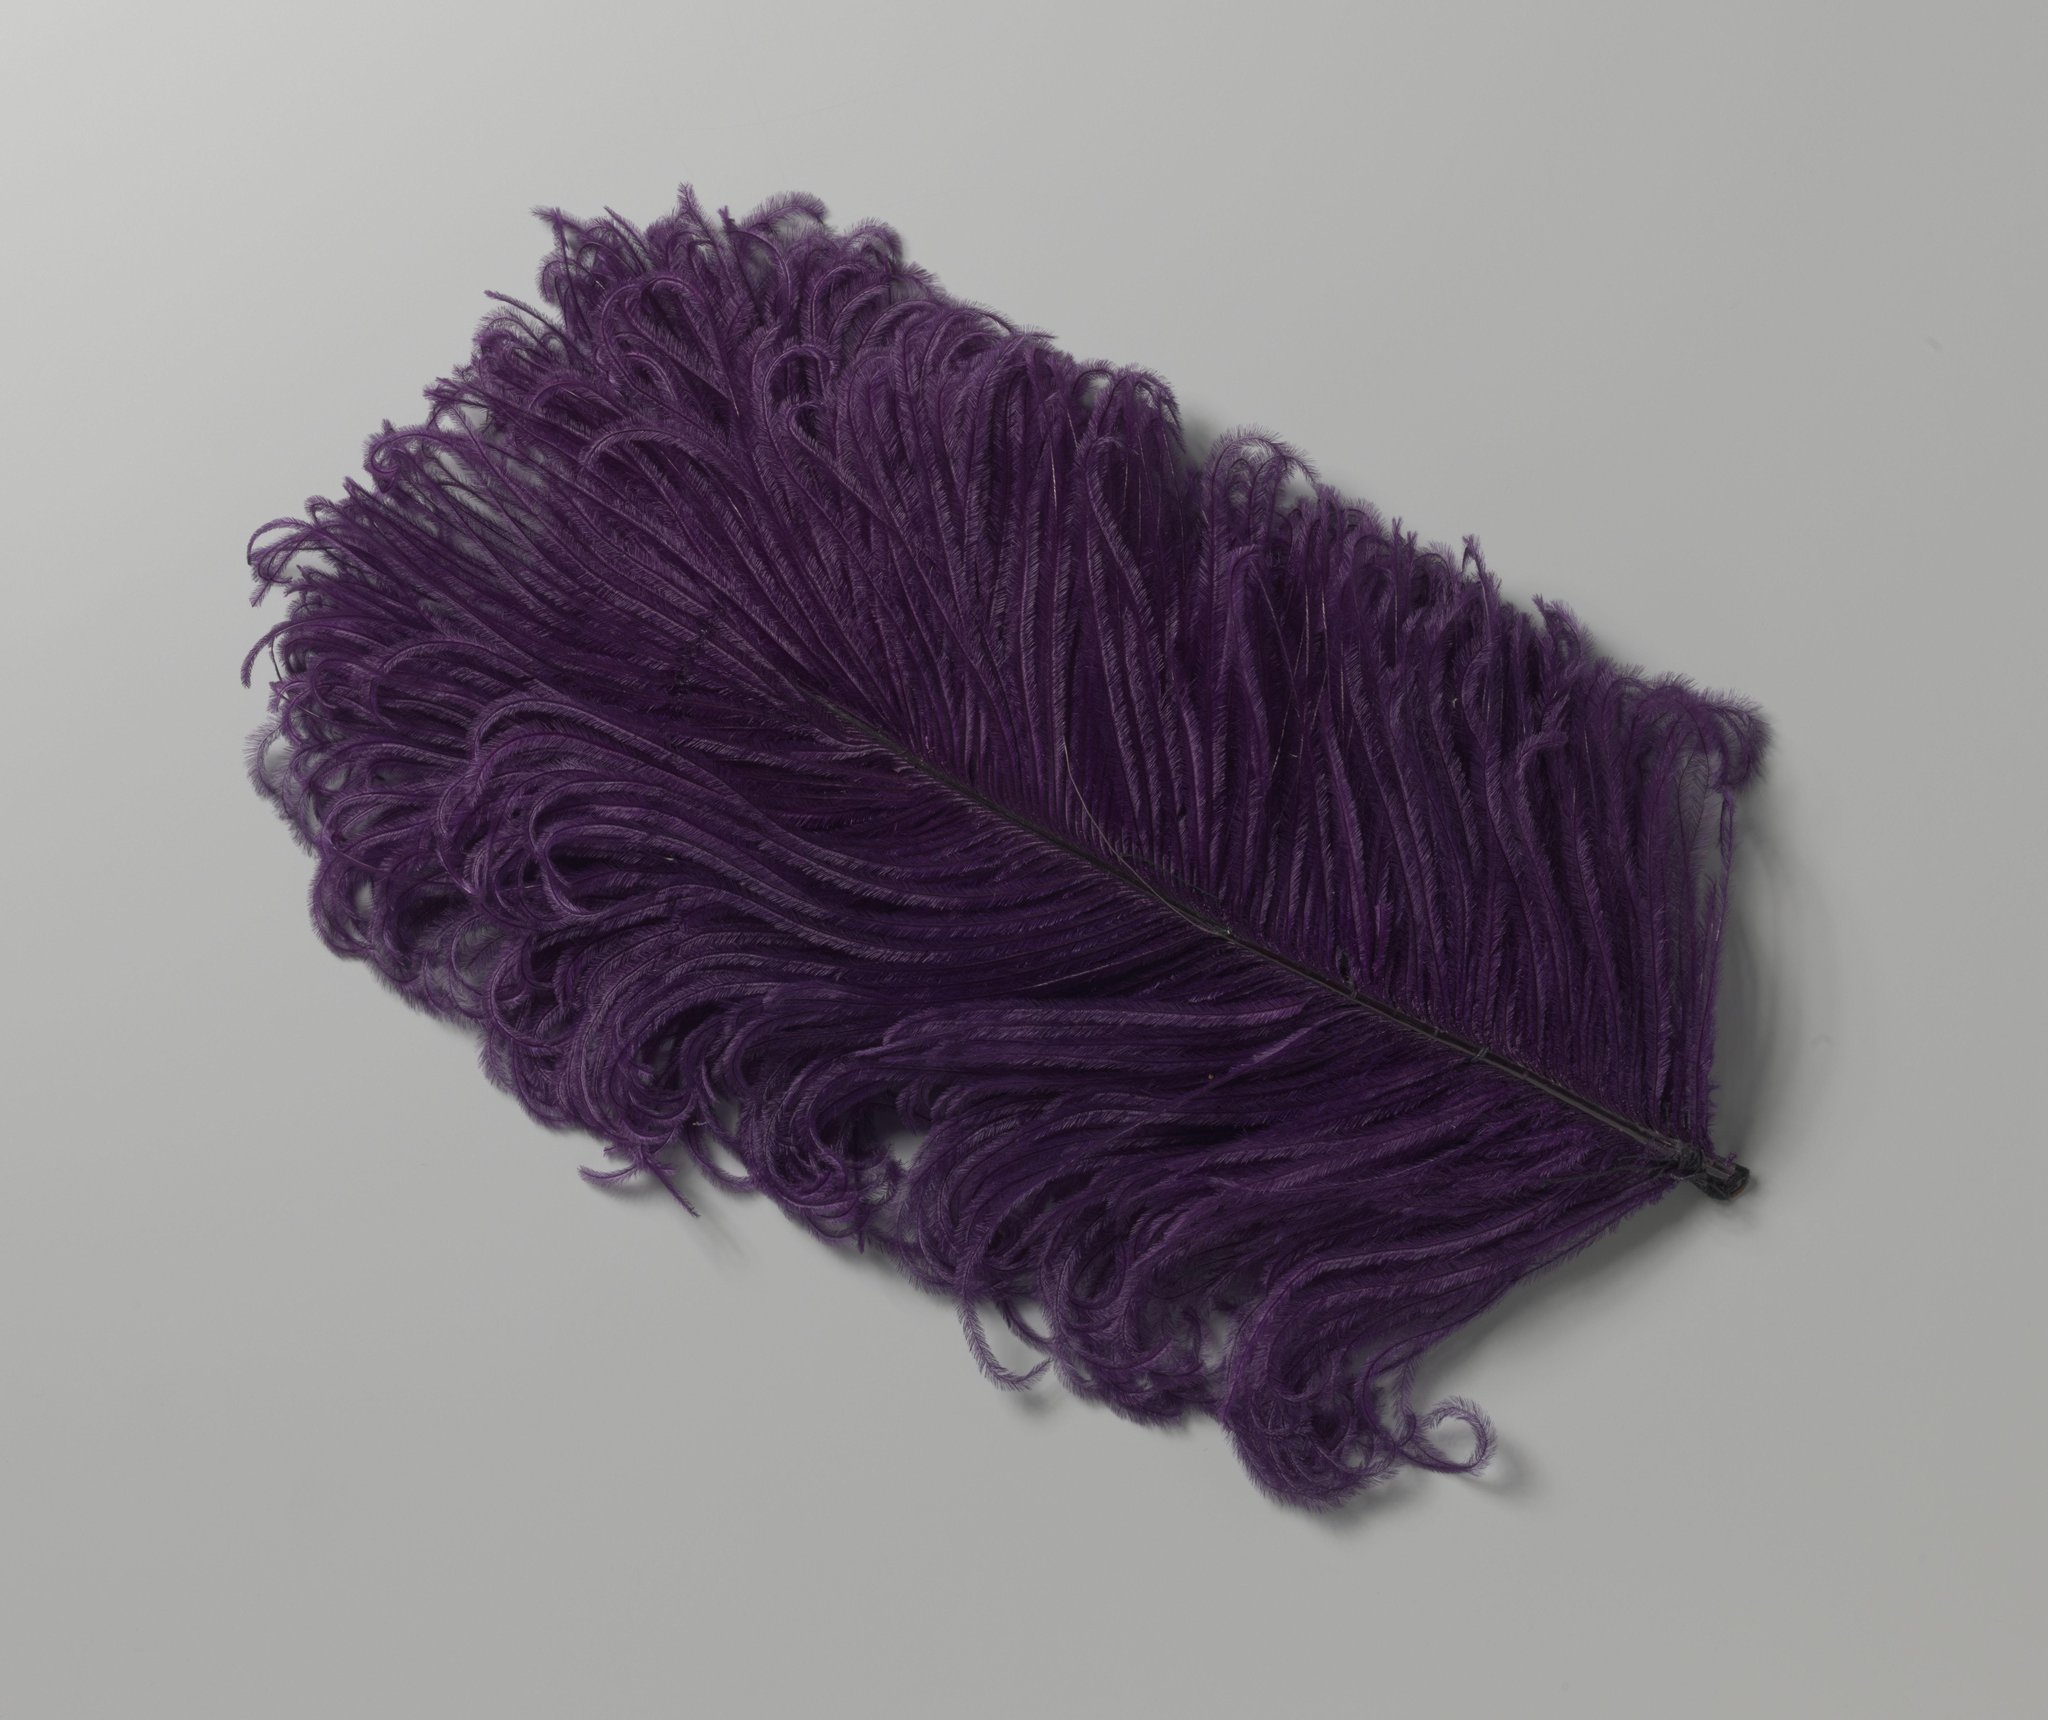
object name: hoedenveer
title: Struisveer, paars van kleur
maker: Anonymous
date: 1895-1915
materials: metal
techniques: painting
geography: western europe